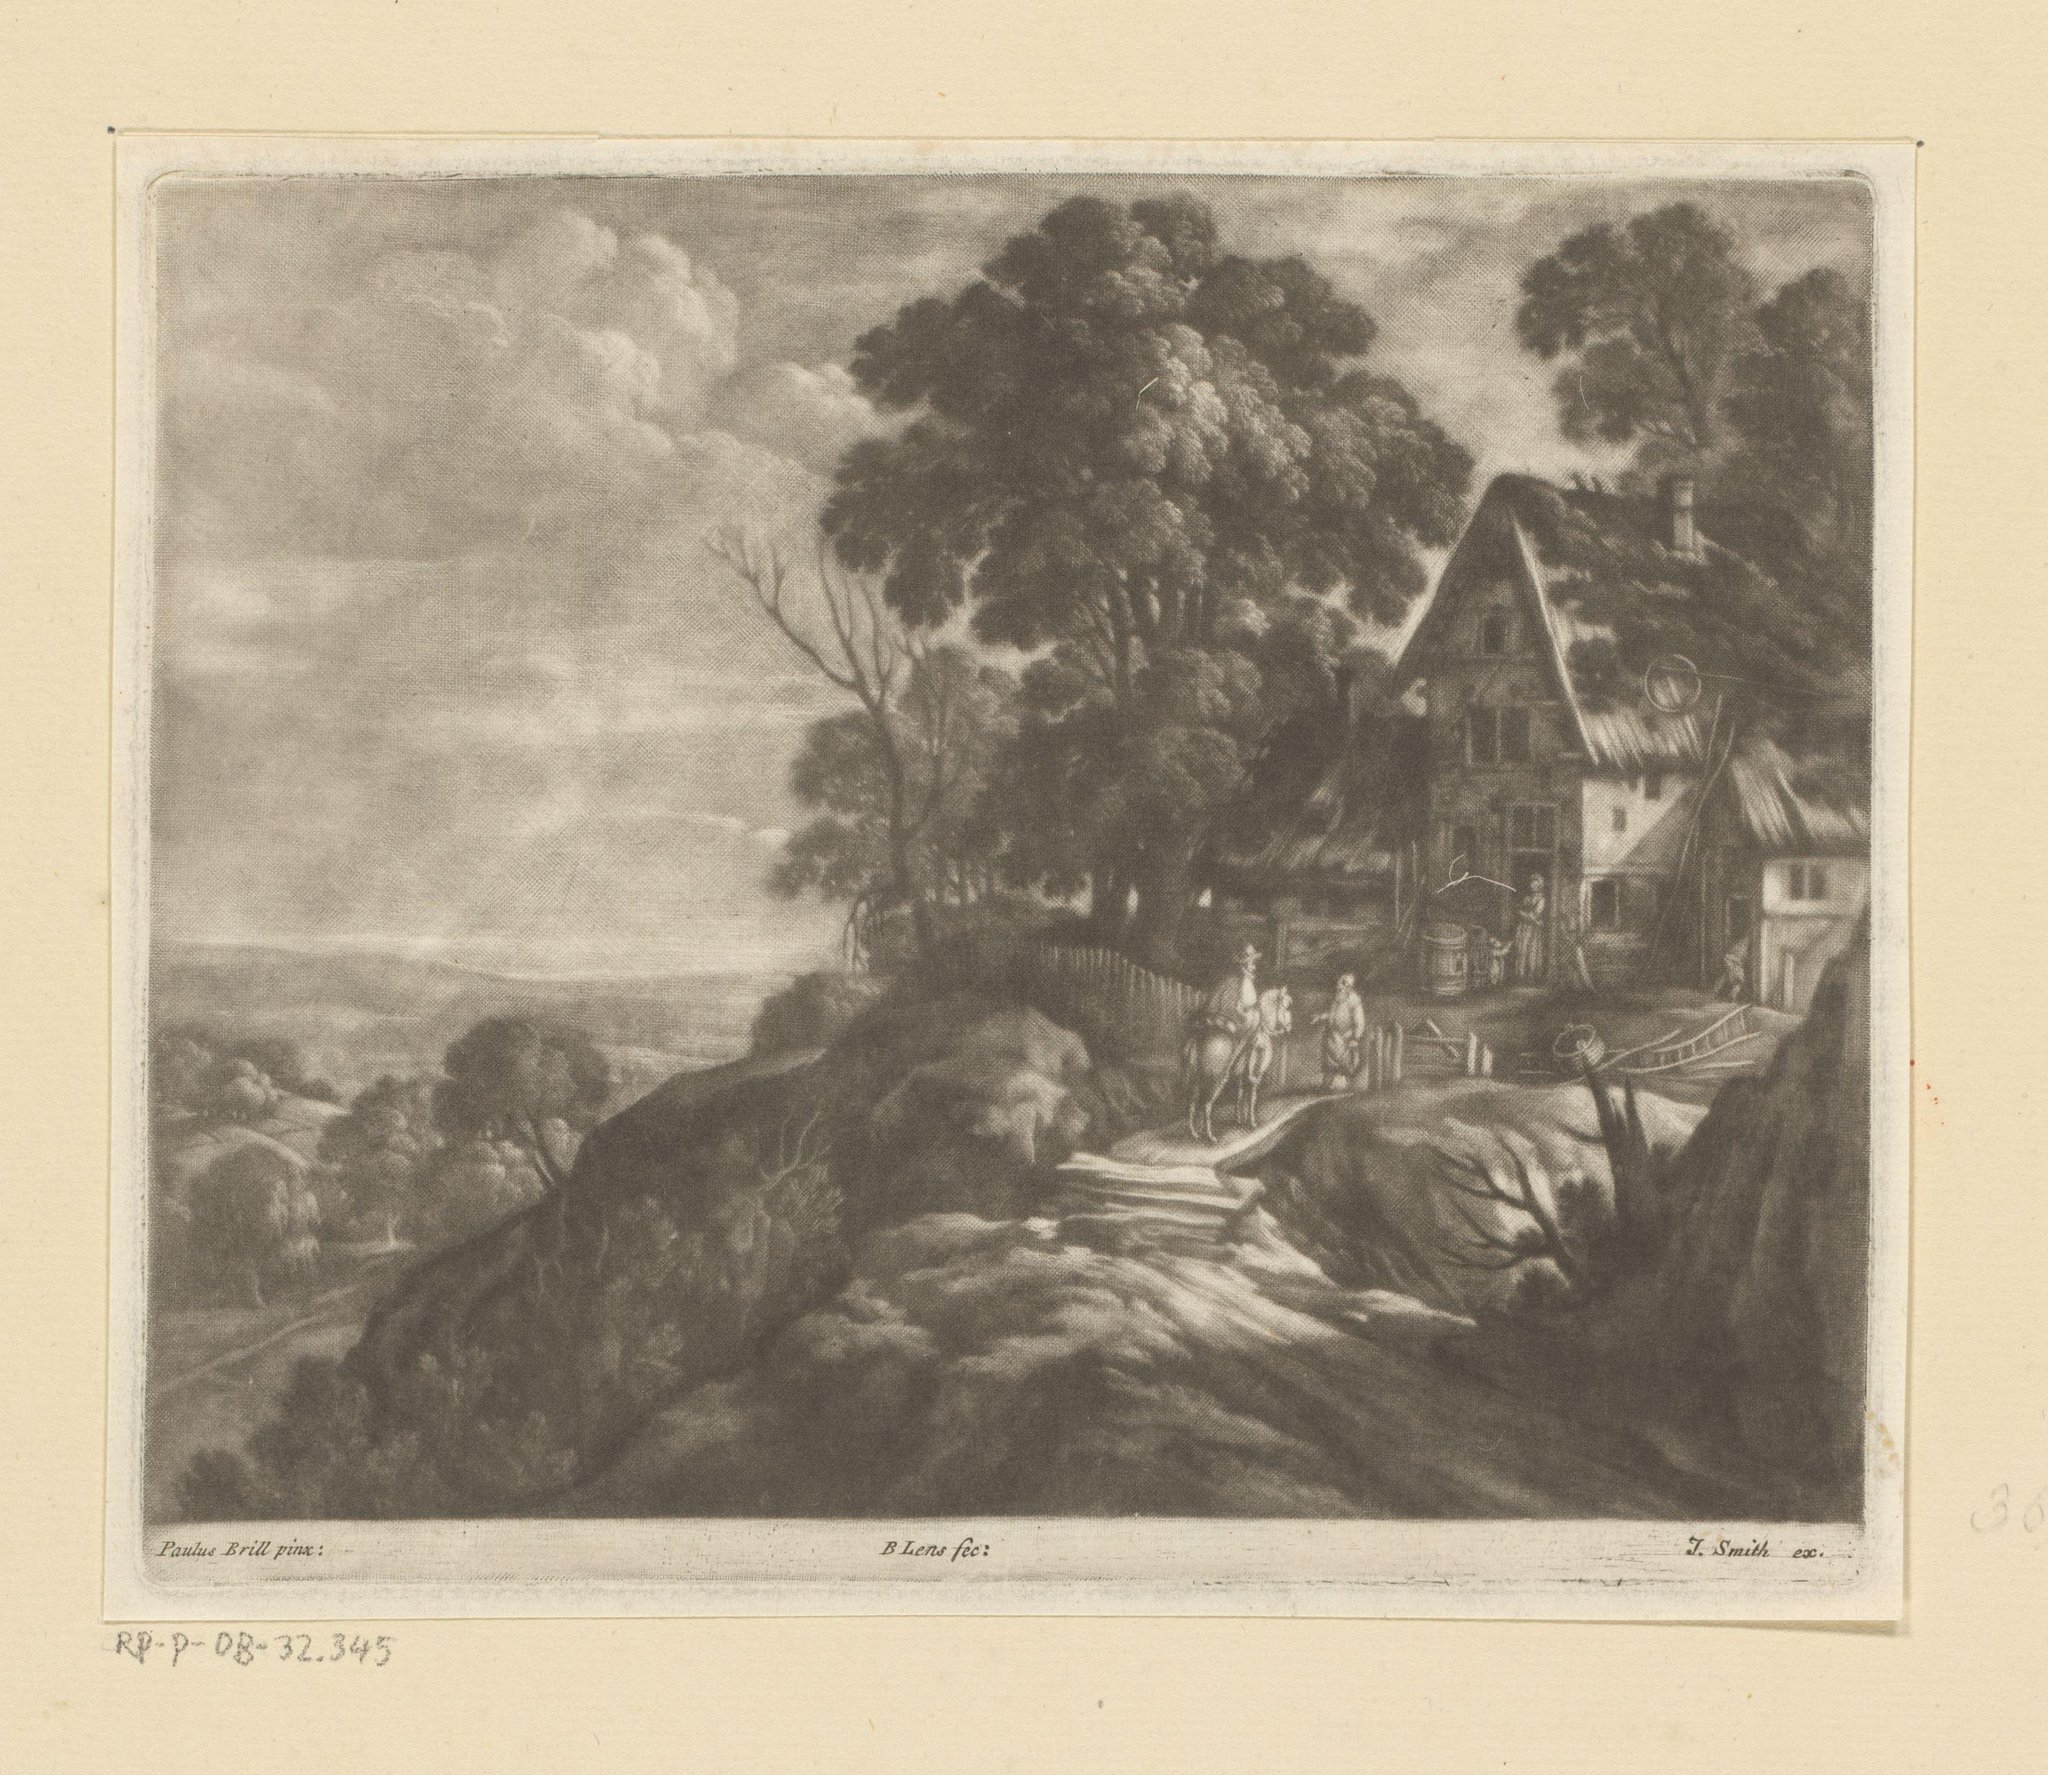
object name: print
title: Landschap met een ruiter bij een huis op een heuvel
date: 1669-1742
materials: paper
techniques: etching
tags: riding a horse, ass, or mule; rider, horseman, (high) hill (+ landscape with figures, staffage)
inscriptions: collector's mark: Lugt 240